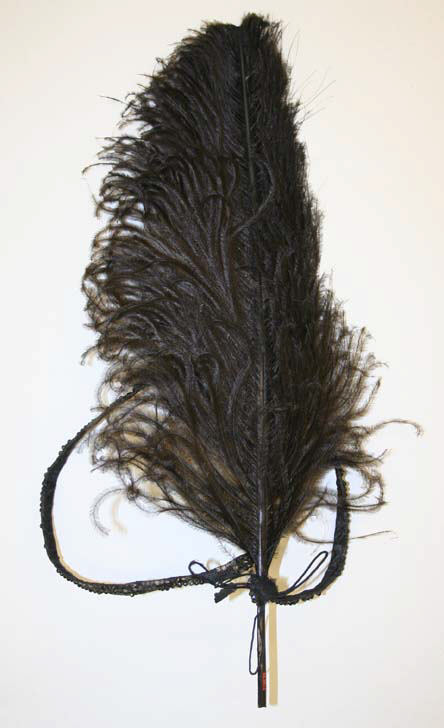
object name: headdress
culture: french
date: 1801-1900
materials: feather